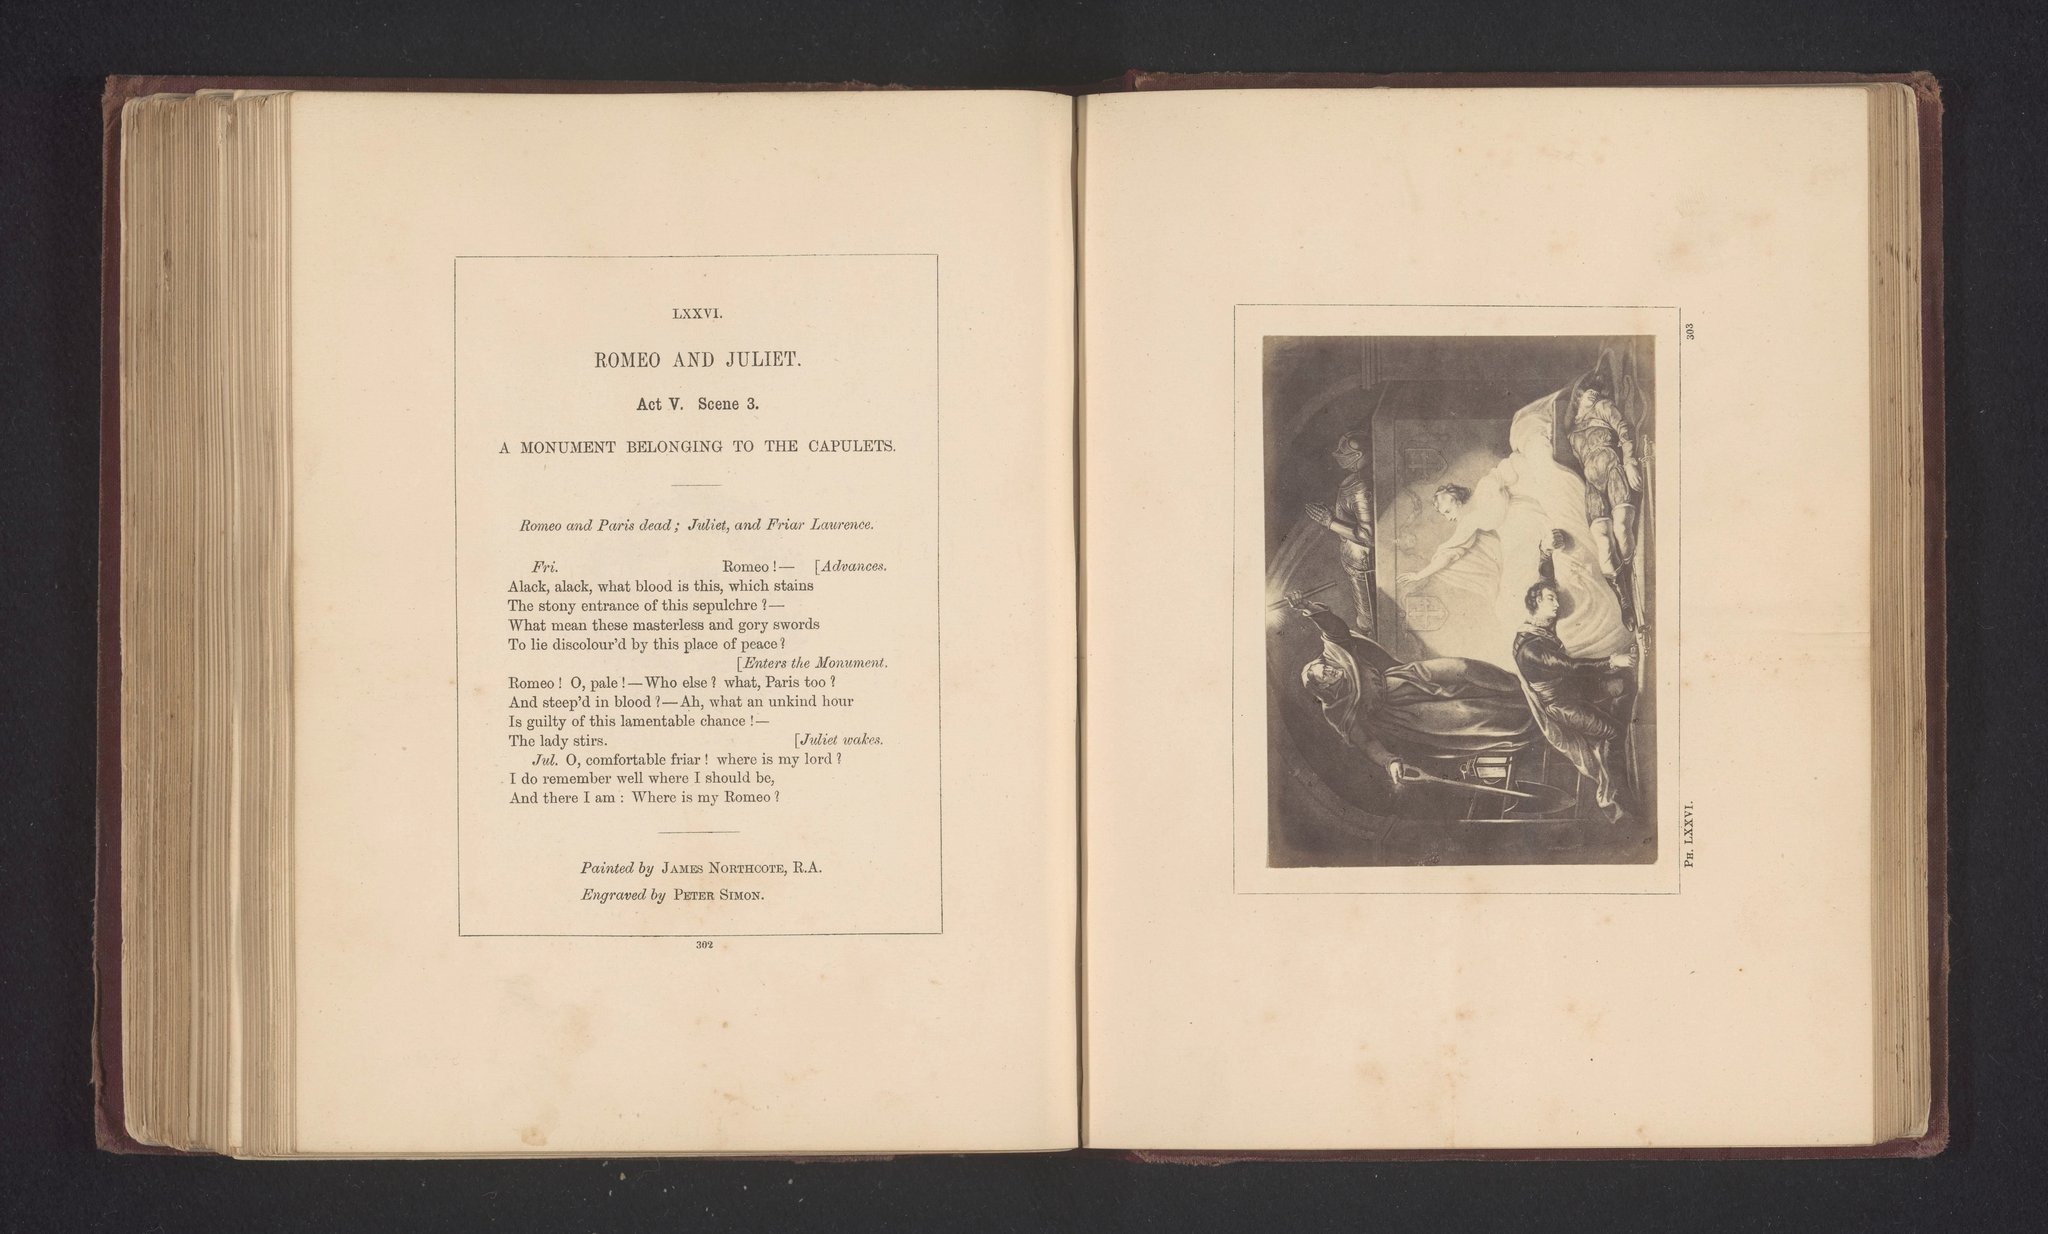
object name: page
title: Fotoreproductie van een prent naar een schilderij door James Northcore, voorstellend een scene uit Romeo en Julia door William Shakespeare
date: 1854-1867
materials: photographic support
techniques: albumen print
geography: london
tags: specific works of literature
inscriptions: number: ‘Ph. LXXVI. 303’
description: Te zien is akte V, scene 3 met Romeo en Paris die zijn overleden en Julia die ontwaakt.